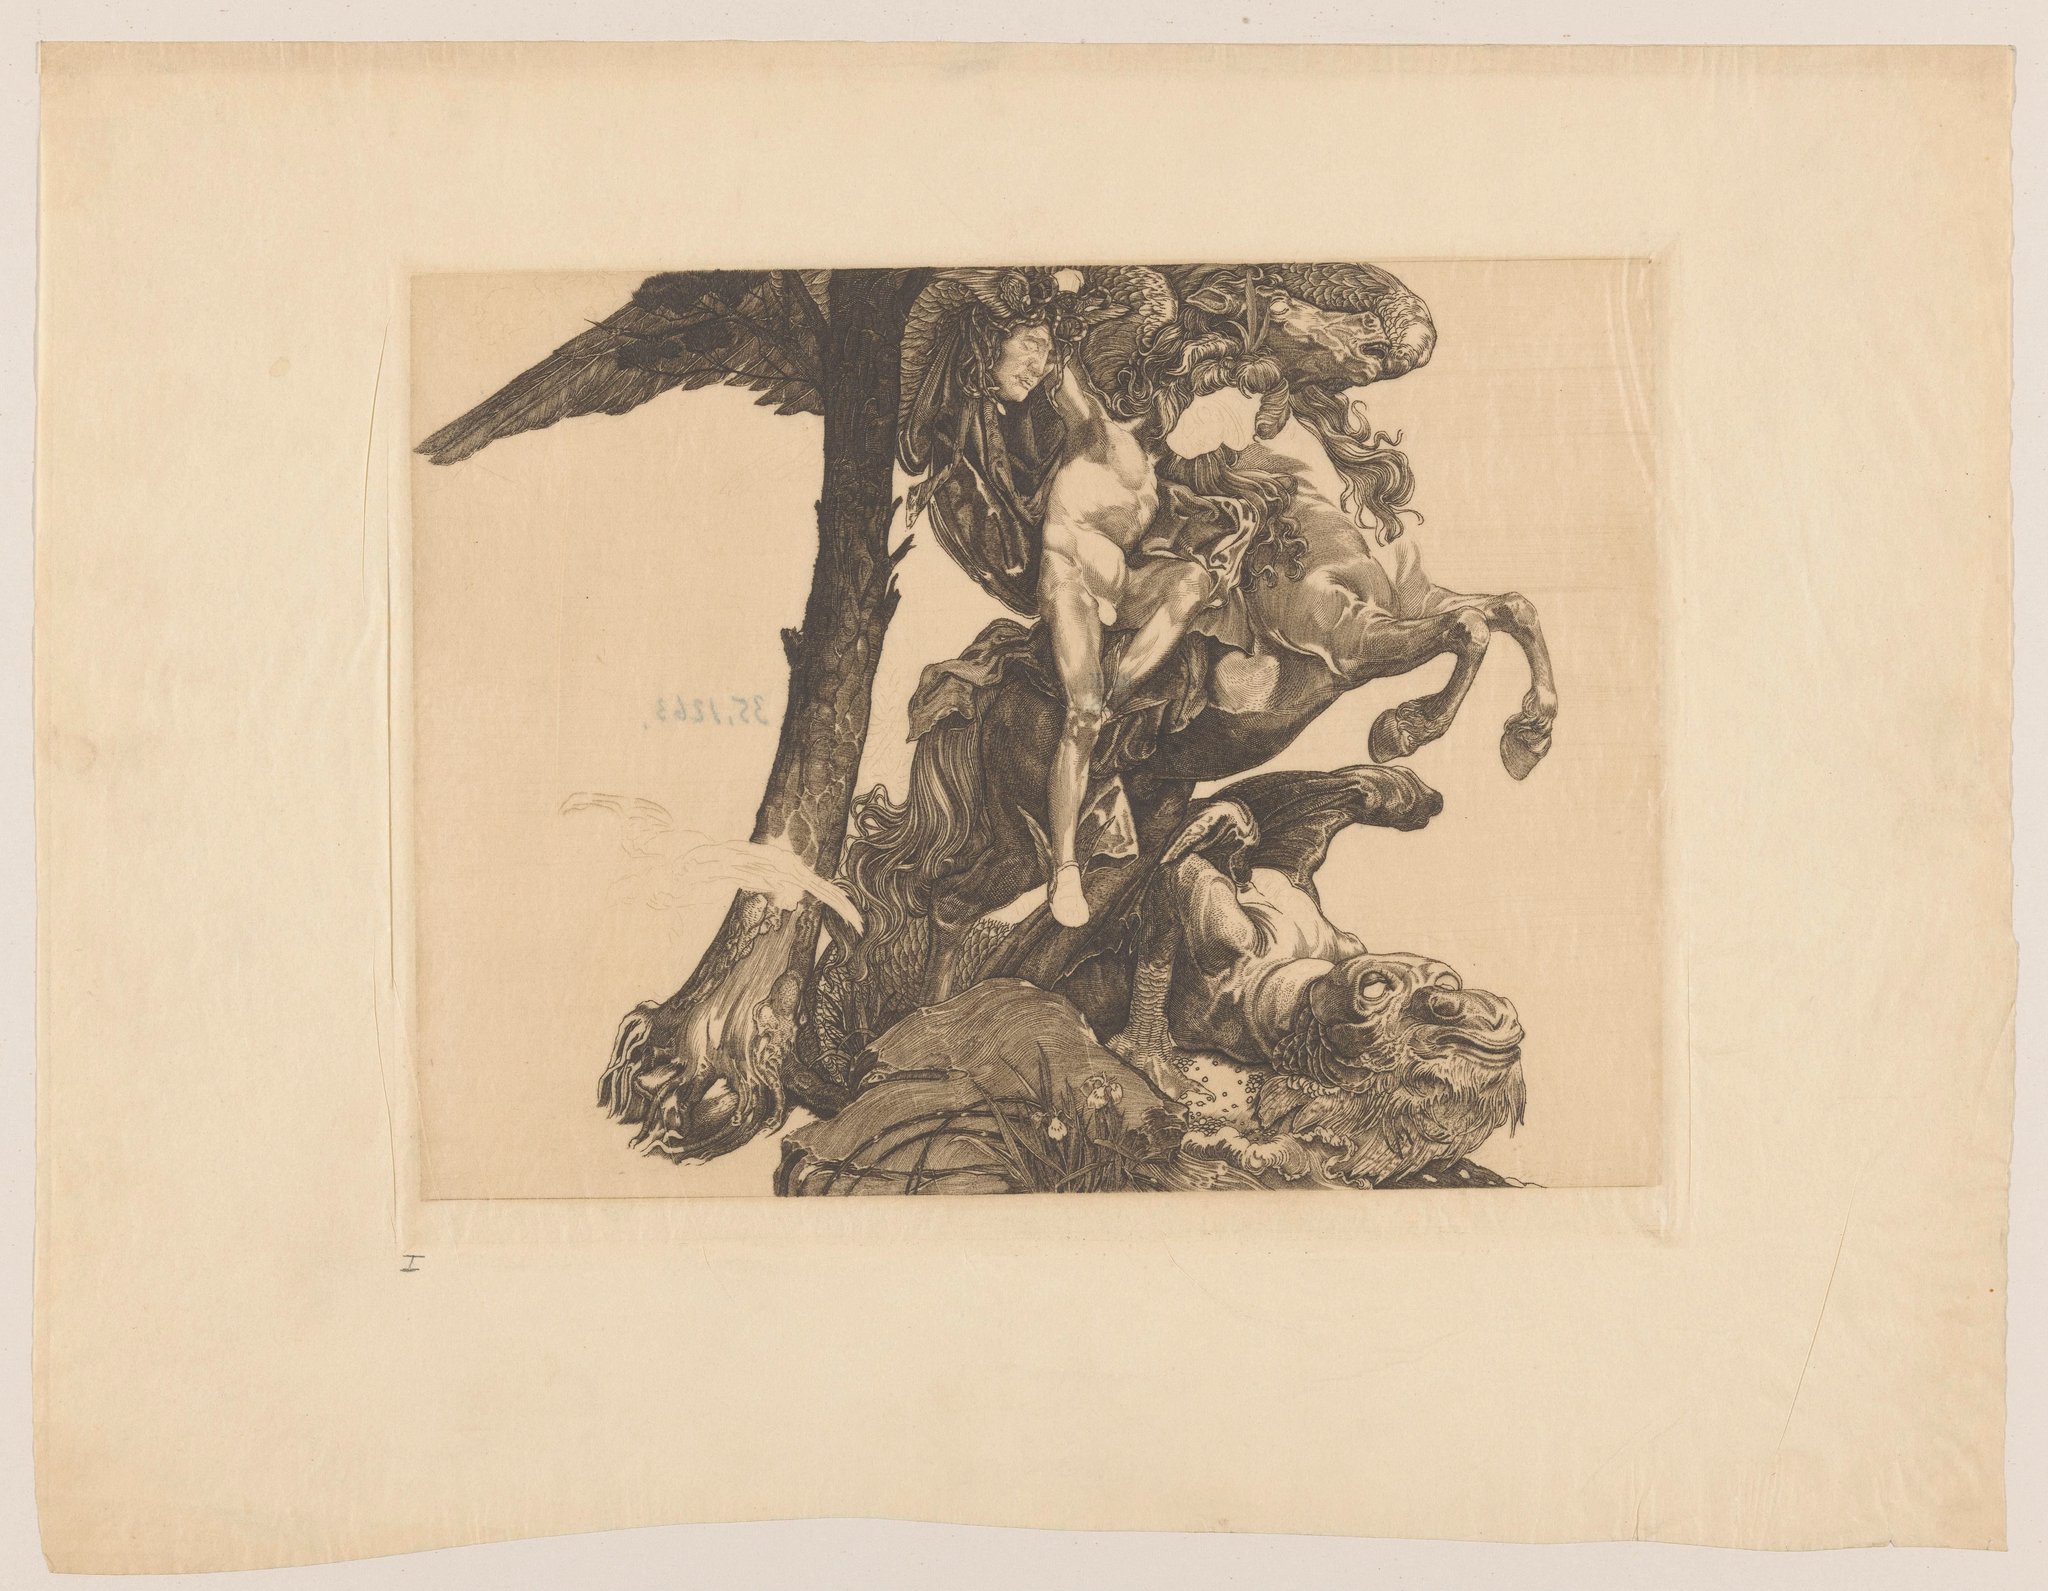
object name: print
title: Perseus en het zeemonster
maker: johannes josephus aarts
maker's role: draughtsman, print maker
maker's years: 1871-1934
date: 1907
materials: paper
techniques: engraving, intaglio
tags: pegasus, the winged horse, (story of) perseus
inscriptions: collector's mark: Lugt 2166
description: Perseus zweeft hangend aan het gevleugelde paard Pegasus door de lucht. Hij houdt het afgehakte hoofd van Medusa boven het zeemonster waaraan Andromeda is geofferd. Links op de voorgrond een vliegende meeuw.